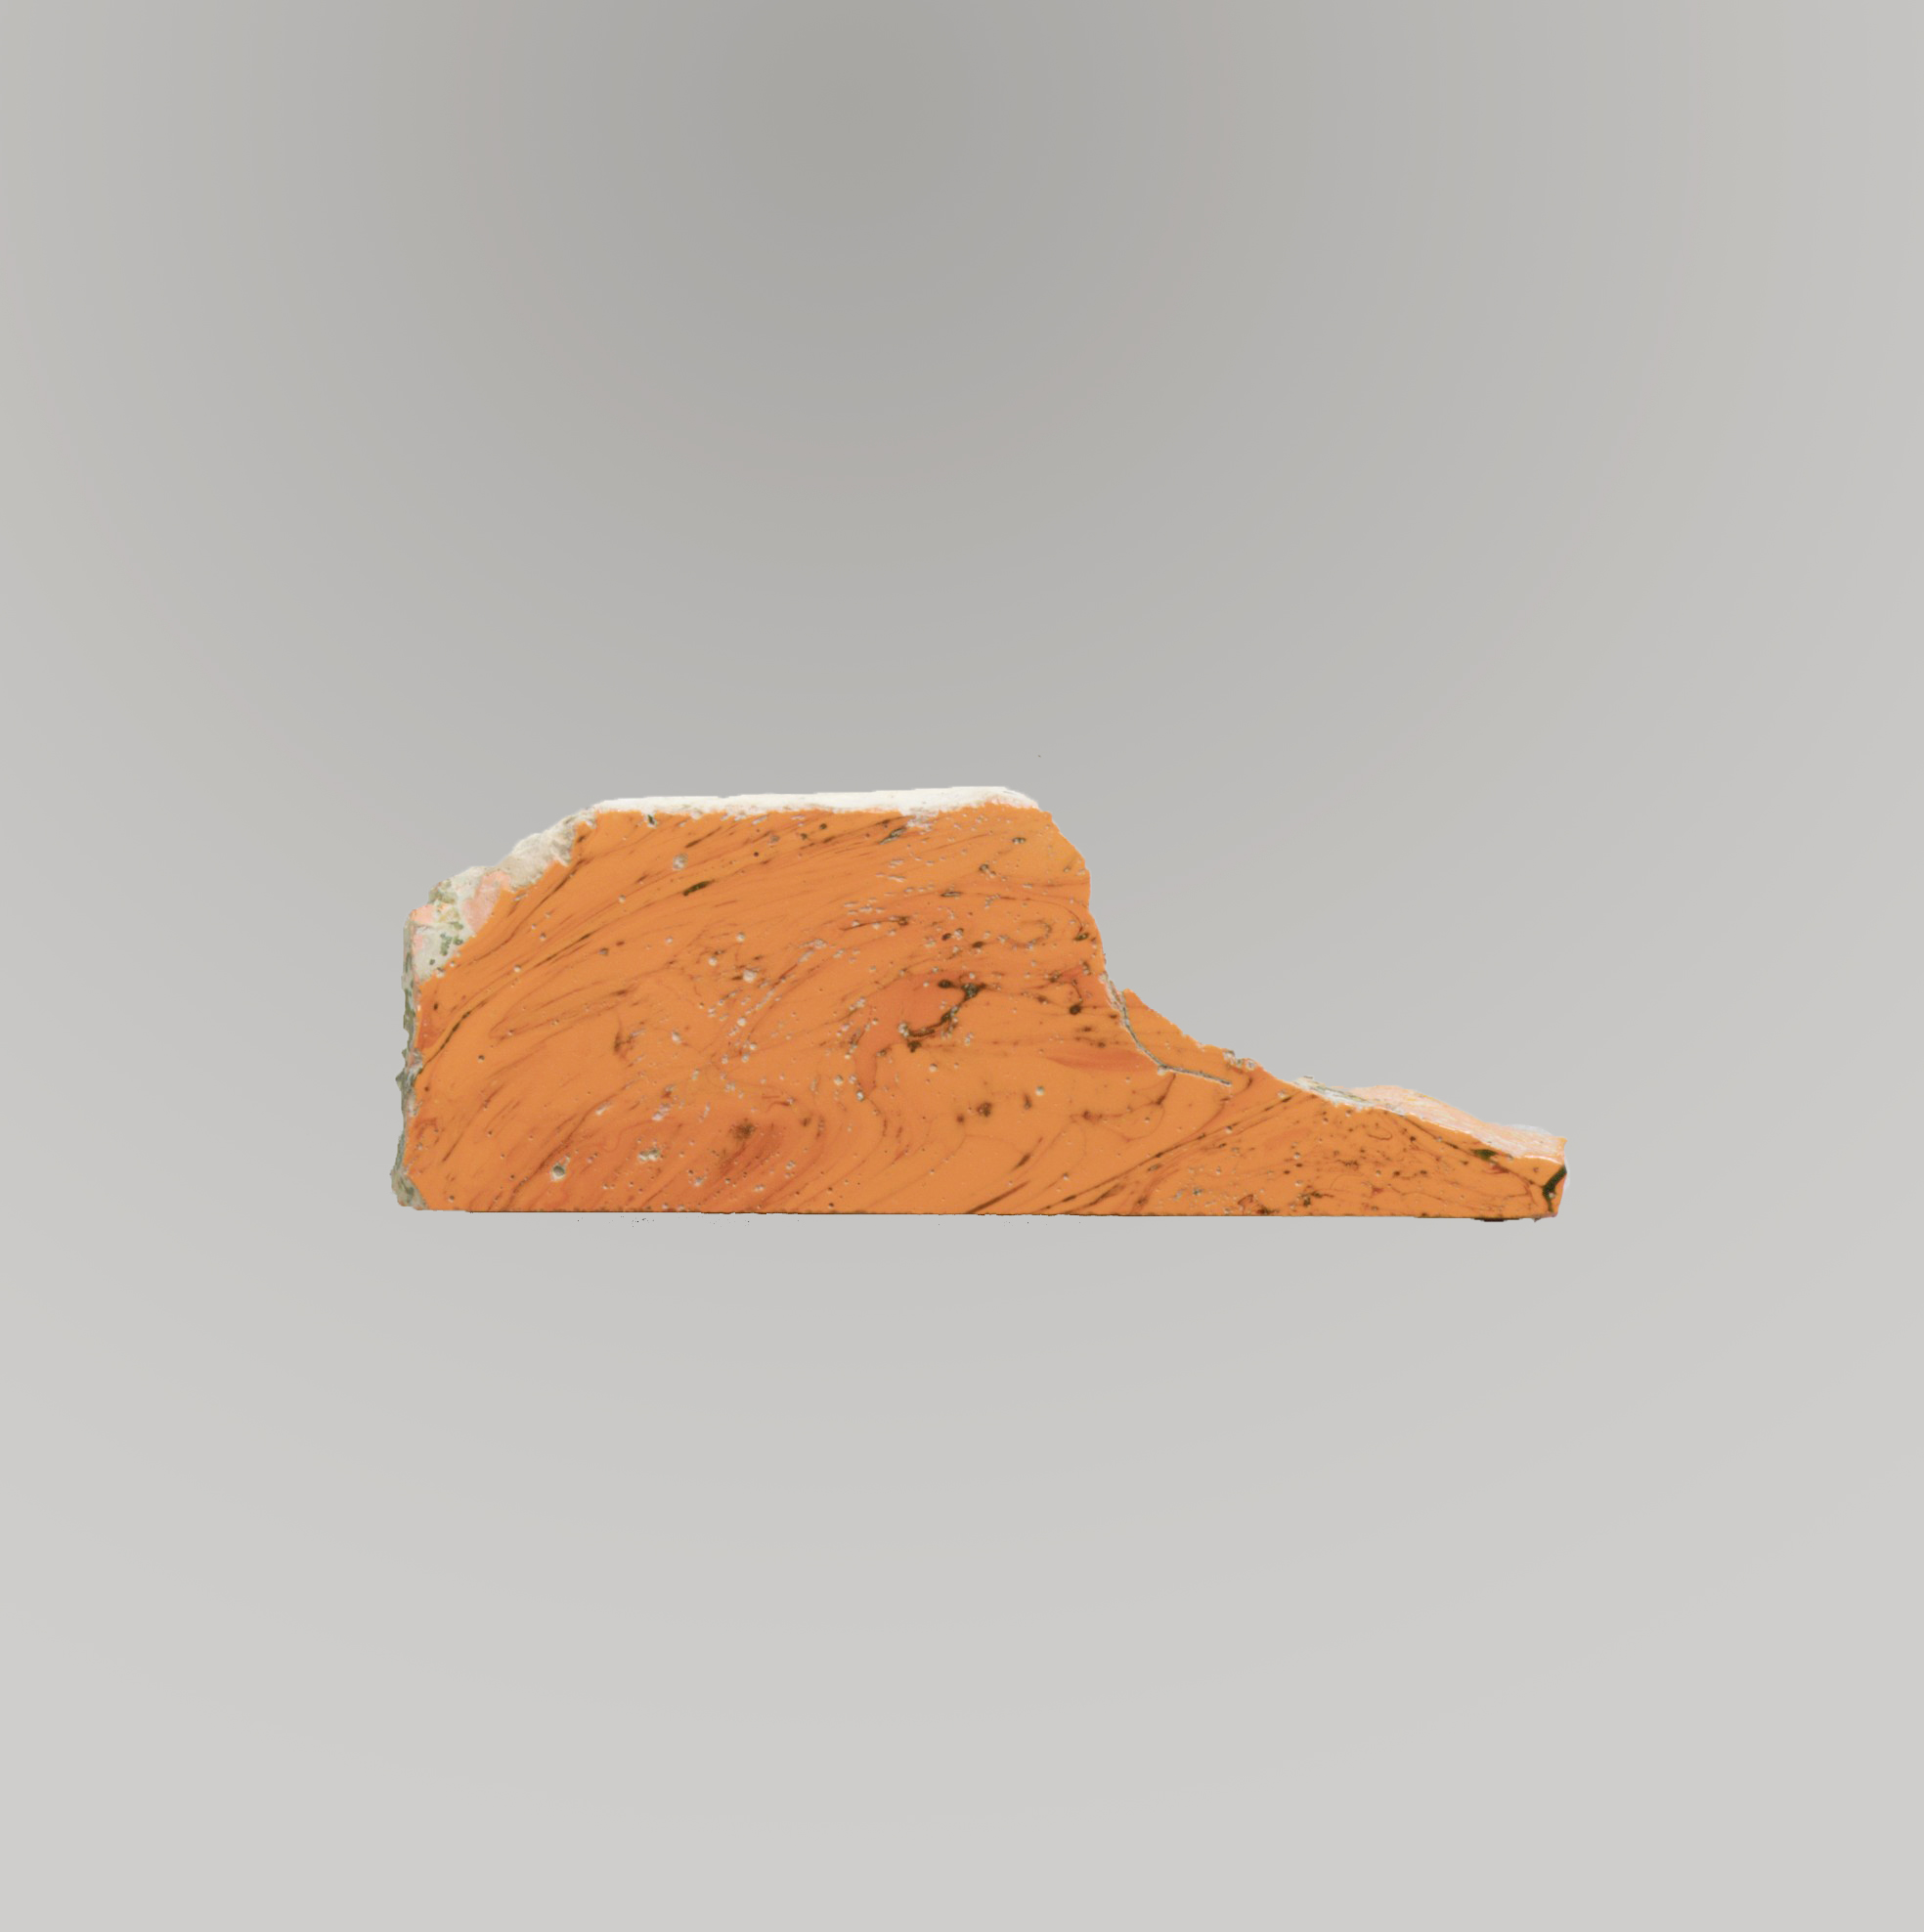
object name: fragment, marbled mosaic inlay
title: Glass marbled mosaic inlay fragment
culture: roman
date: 1-50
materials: glass